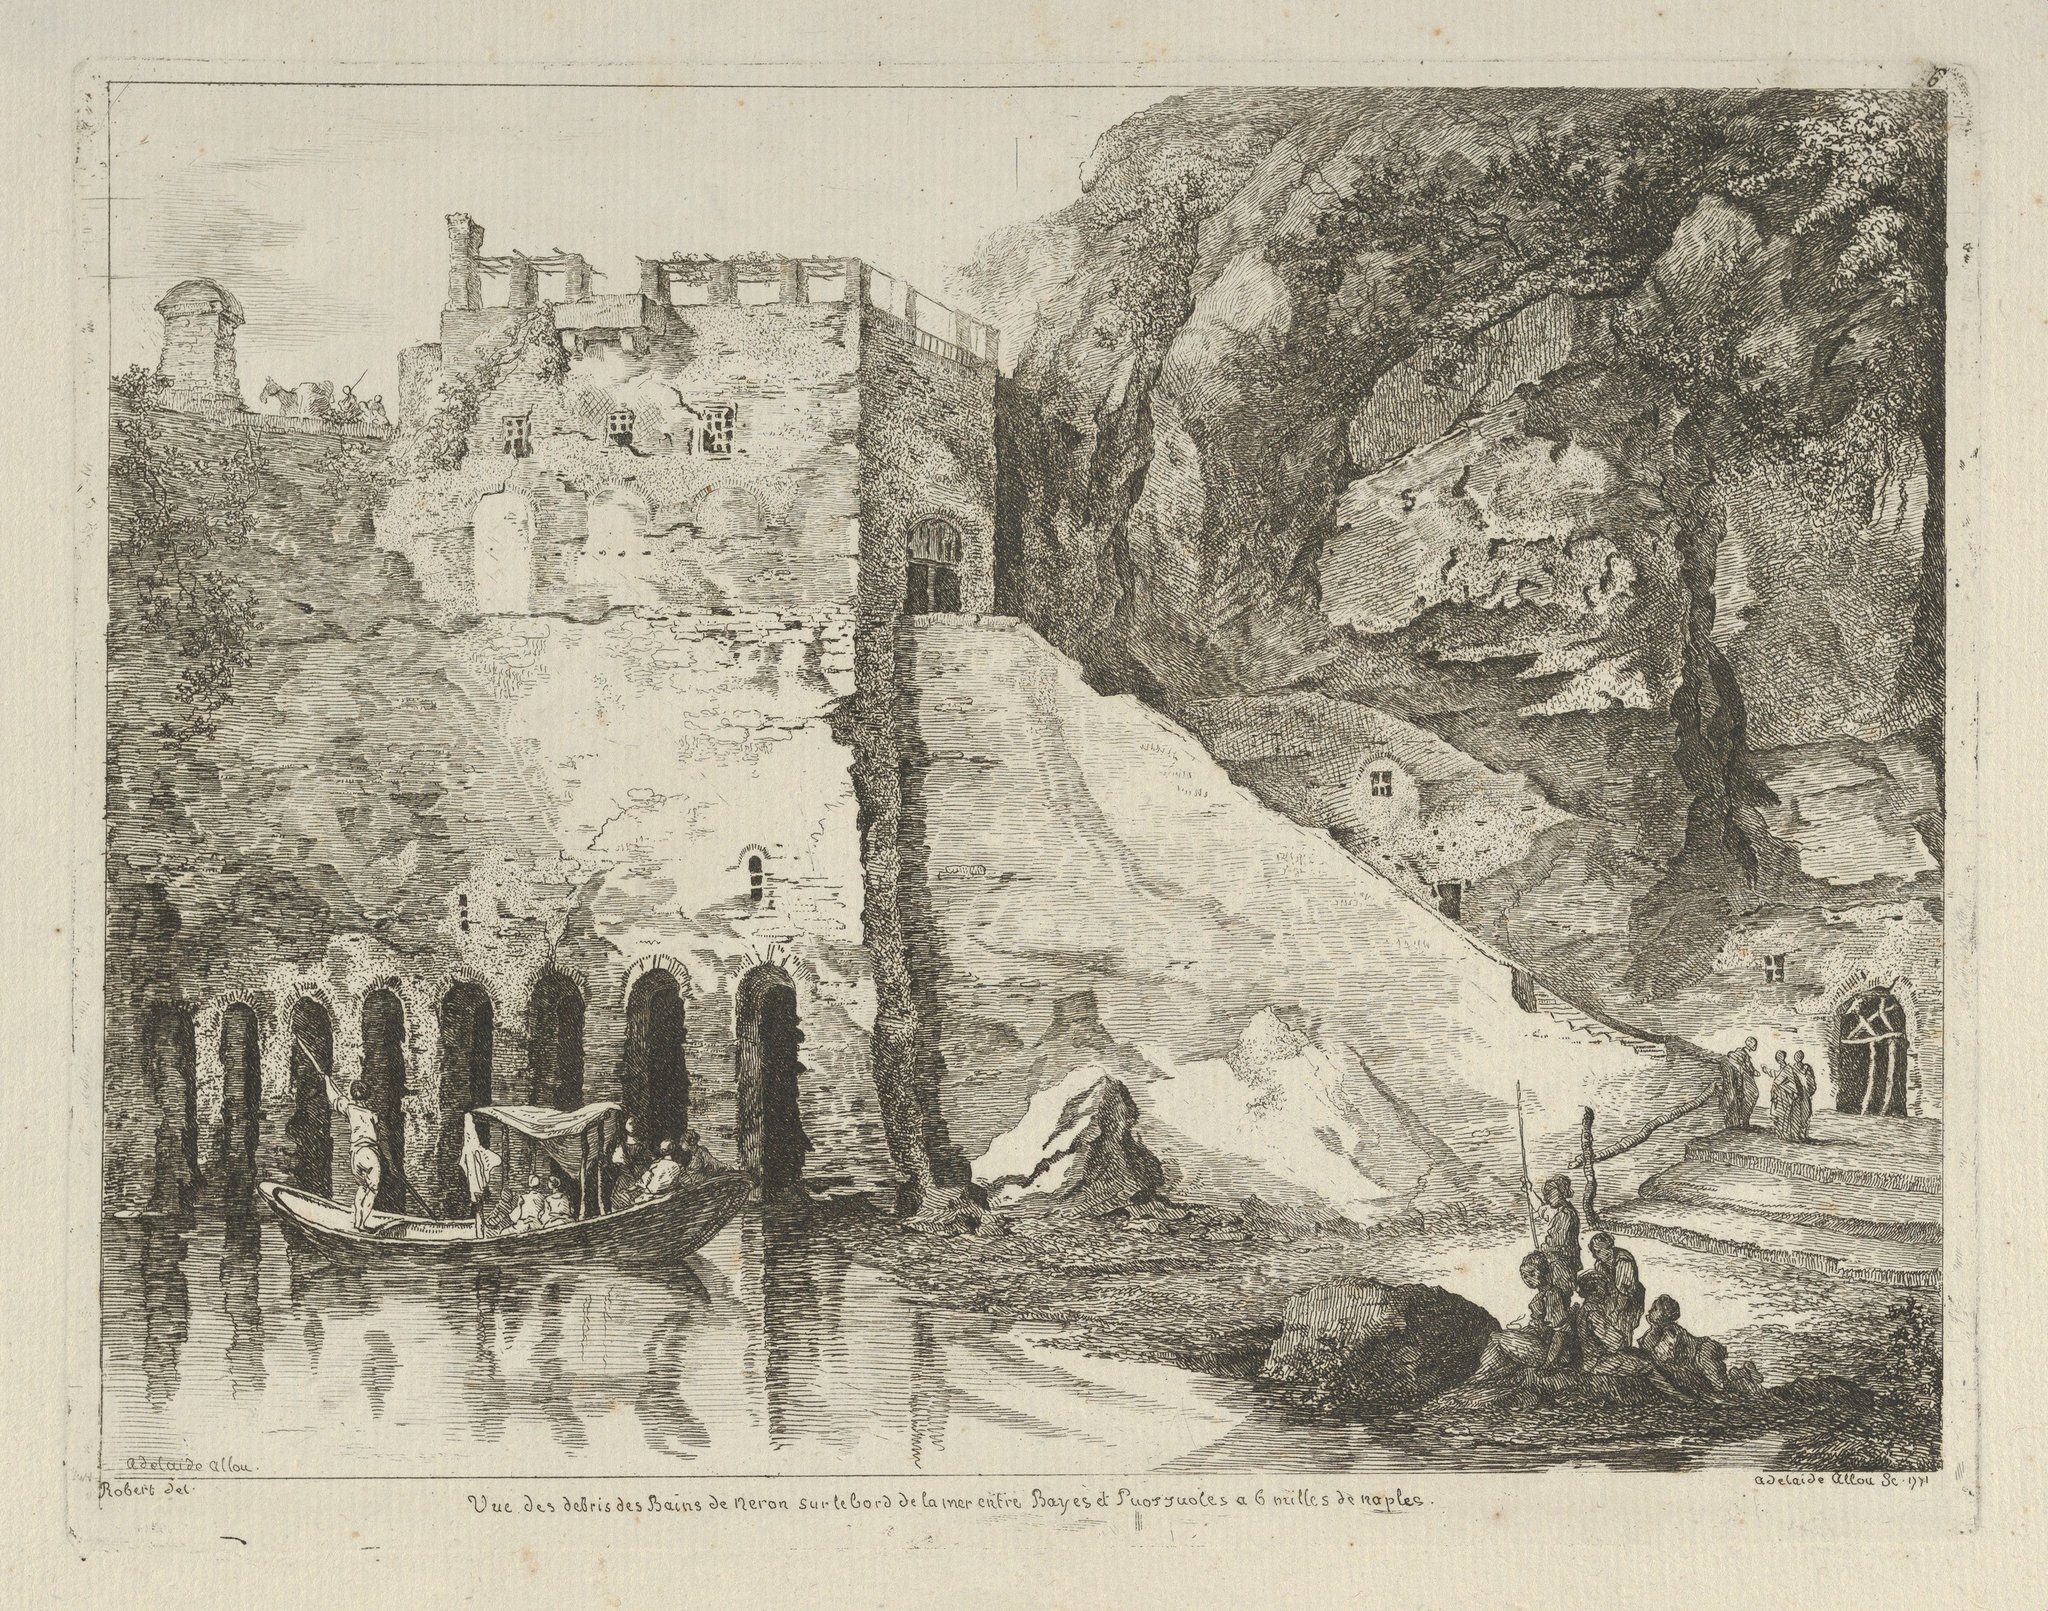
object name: print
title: Vue des debris des bains de Neron from Differentes vues dessiné d'après nature... dans les environs de Rome et de Naples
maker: adélaide allou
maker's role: artist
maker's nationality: french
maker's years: 1776-1800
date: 1701-1800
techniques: etching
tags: buildings,boats